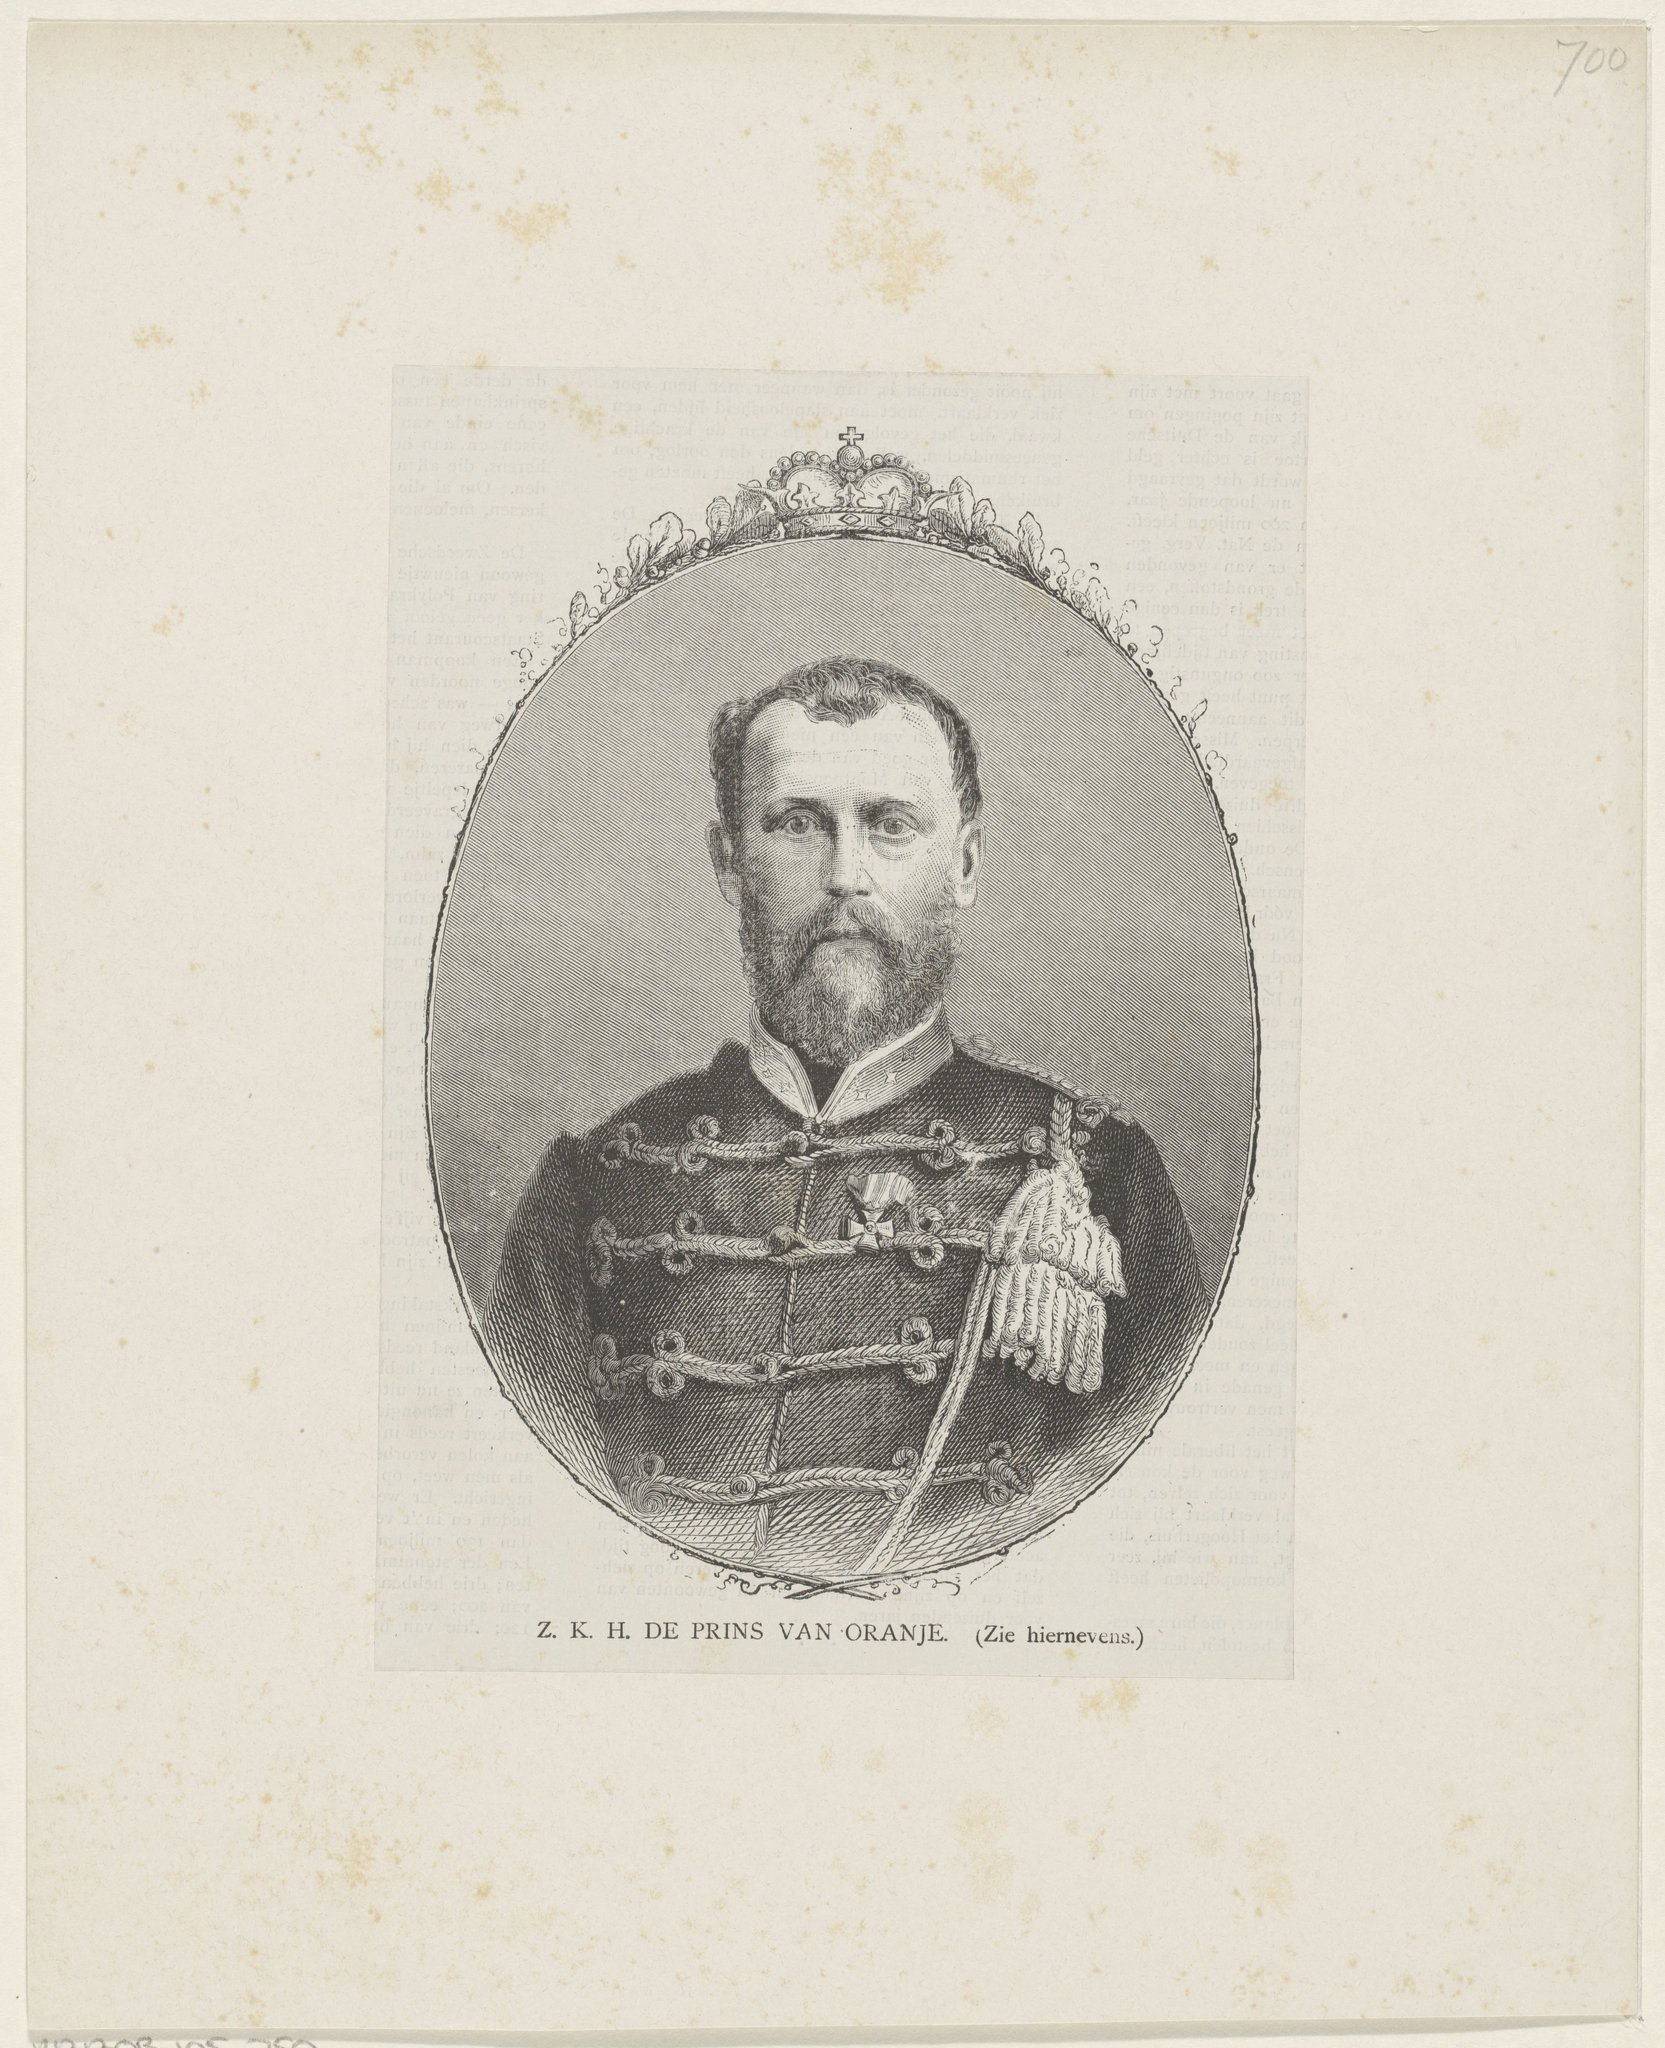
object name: print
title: Portret van Willem, prins der Nederlanden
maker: Anonymous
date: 1865-1949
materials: paper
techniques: letterpress printing, engraving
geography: netherlands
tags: paris, willem (prins der nederlanden)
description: De hier vermelde titel verwijst naar de hoogst verkregen titel van de geportretteerde, niet per se naar de titel die de geportretteerde op deze voorstelling draagt.